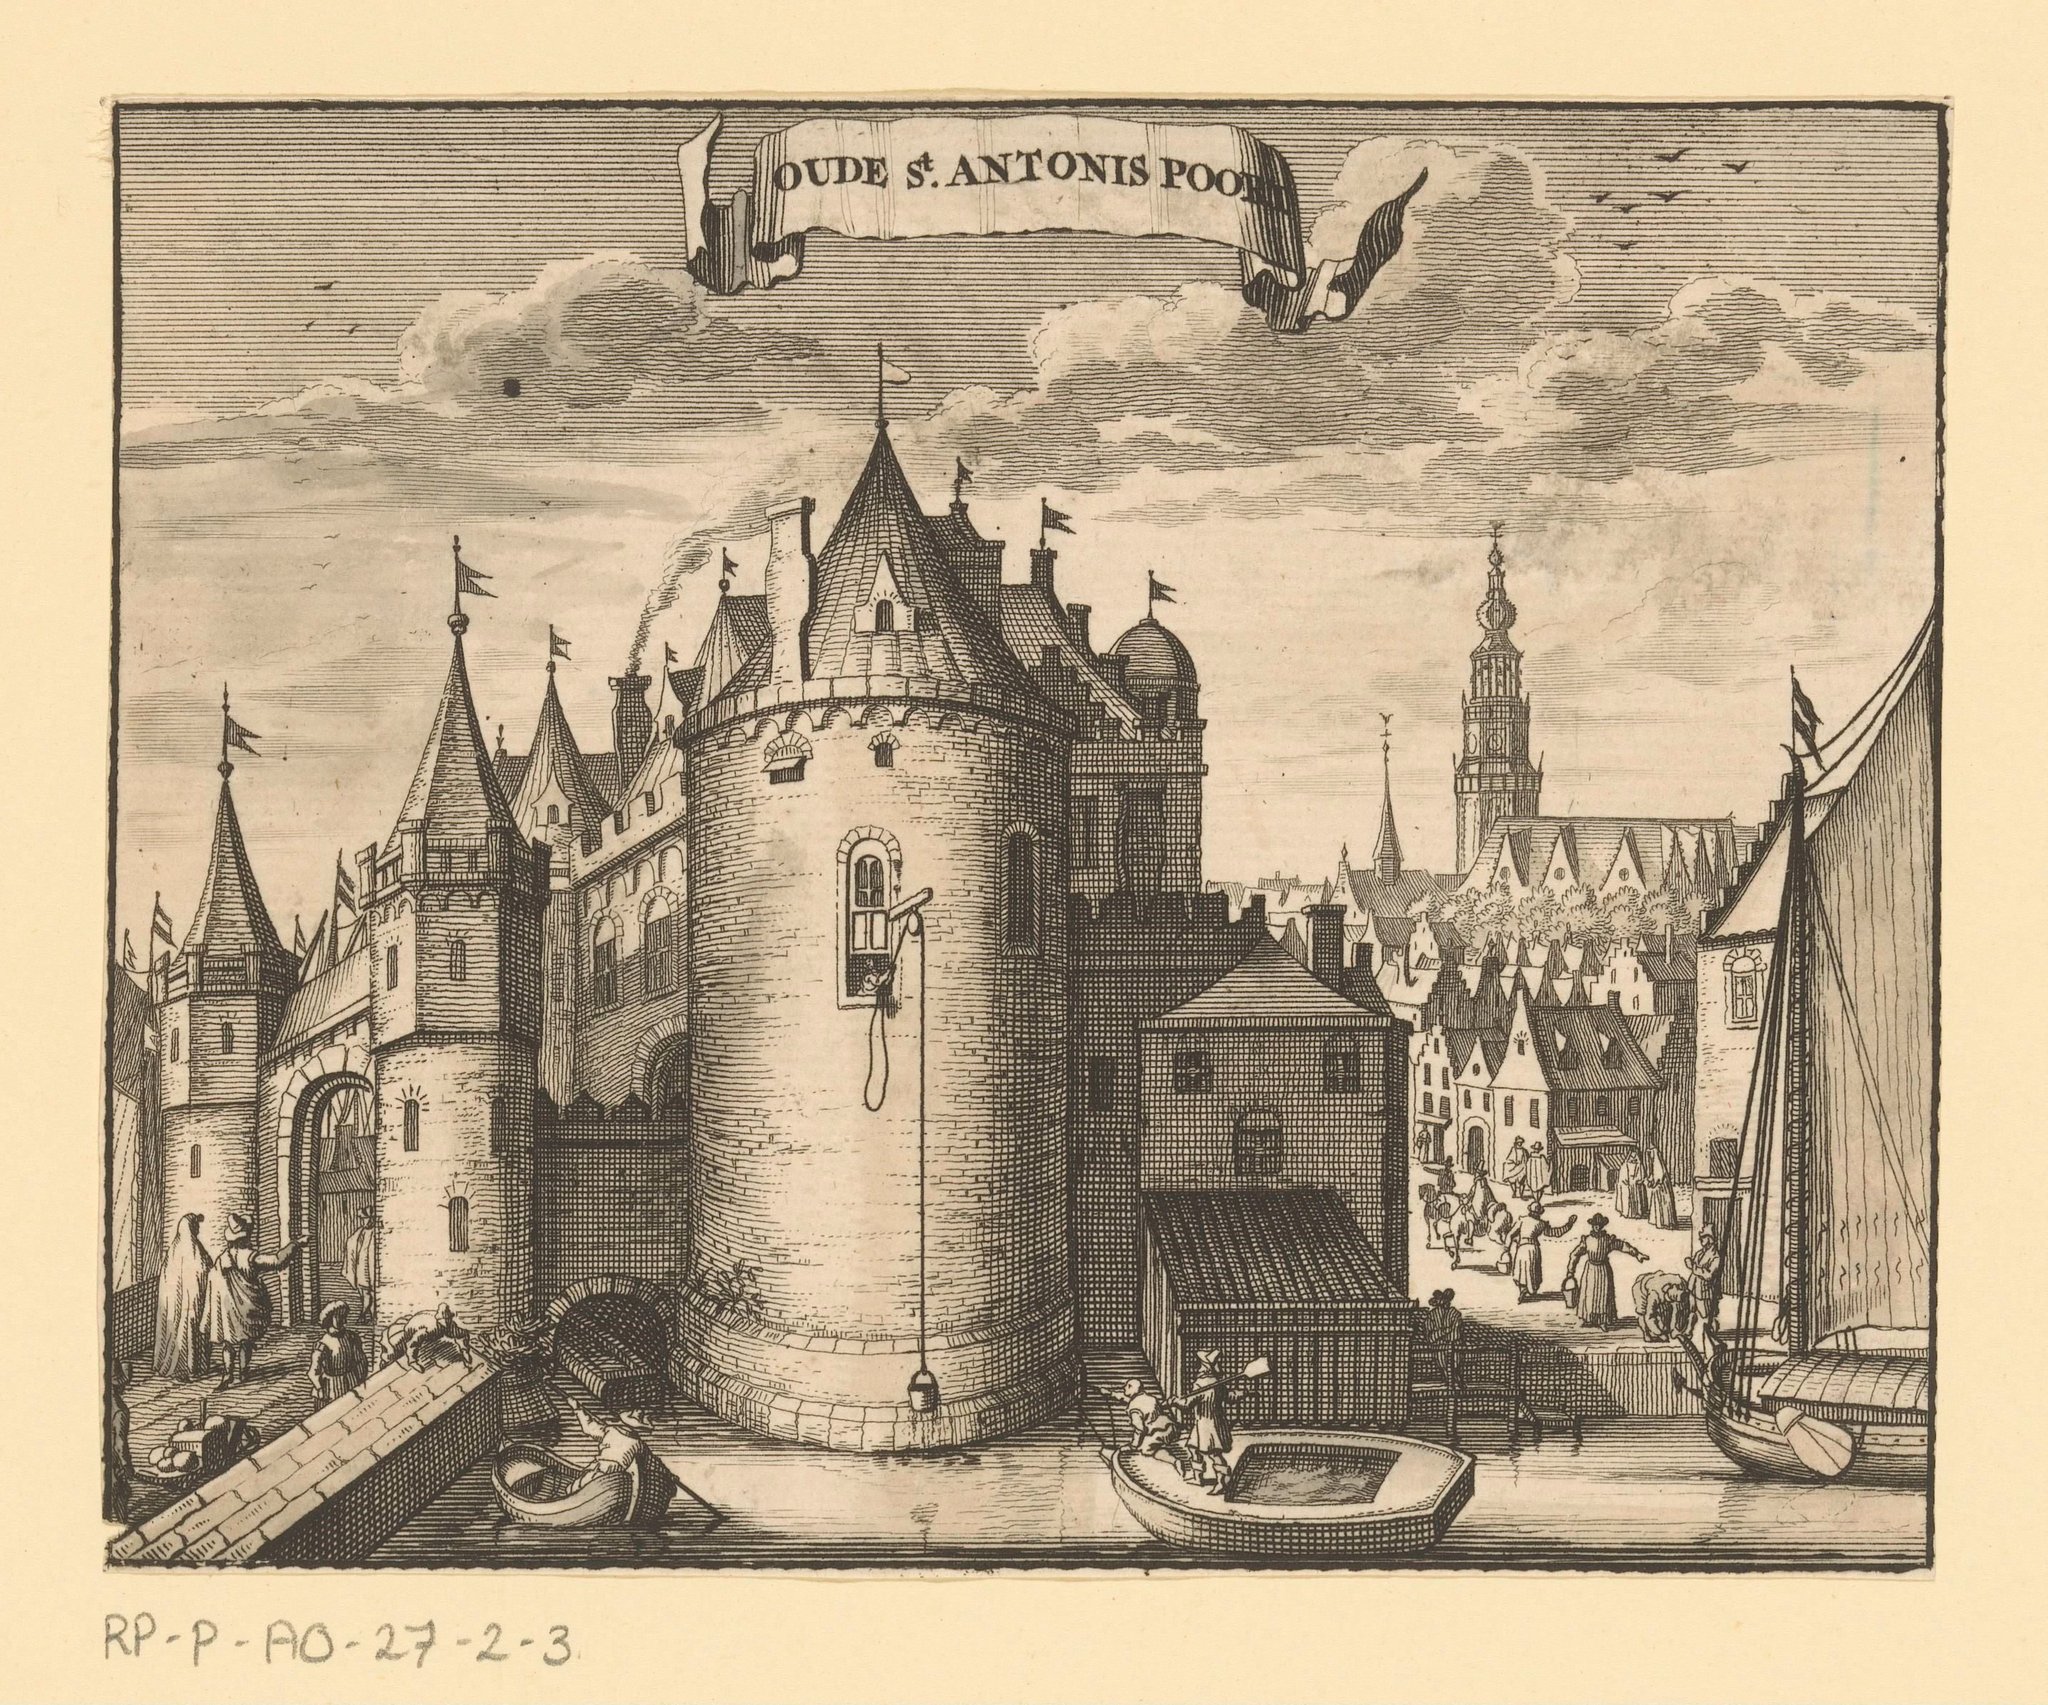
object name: print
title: Gezicht op de Eerste Sint-Antoniespoort te Amsterdam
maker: Anonymous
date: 1693-1726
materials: ink, paper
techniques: brush, engraving, etching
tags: church (exterior), city-gate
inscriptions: collector's mark: Lugt 195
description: Huidige staat van prent ook gebruikt in: Commelin, Caspar. Beschryvinge van Amsterdam, desselfs eerste oorspronk uyt den Huyse (…). 2 delen. Amsterdam: Abraham Wolfgang, Gillis Janssonius van Waesberge, Johannes Janssonius van Waesberge II, weduwe Dirk Boom I, Hendrick Boom en Rembertus Goethals, 1693. En in: Commelin, Caspar. Beschryvinge van Amsterdam, zynde een naukeurige verhandelinge van desselfs eerste oorspronk uyt (…). 2 delen. Amsterdam: weduwe Aart Dircksz Oossaan, 1694. Latere staat ook gebruikt in: Commelin, Caspar. Beschryvinge van Amsterdam, zynde een naukeurige verhandelinge van desselfs eerste oorspronk uyt (…). 2 delen. 2e druk. Amsterdam: Andries van Damme, Johannes Ratelband, weduwe A. van Aaltwyk en Hermanus Uytwerf, 1726. Op deze prent zijn, waarschijnlijk ter voorbereiding van de tweede staat, met penseel in grijs bijwerkingen aangebracht. Deze bijwerking komen overeen met de aanpassingen op de tweede staat (zie RP-P-2017-10358).